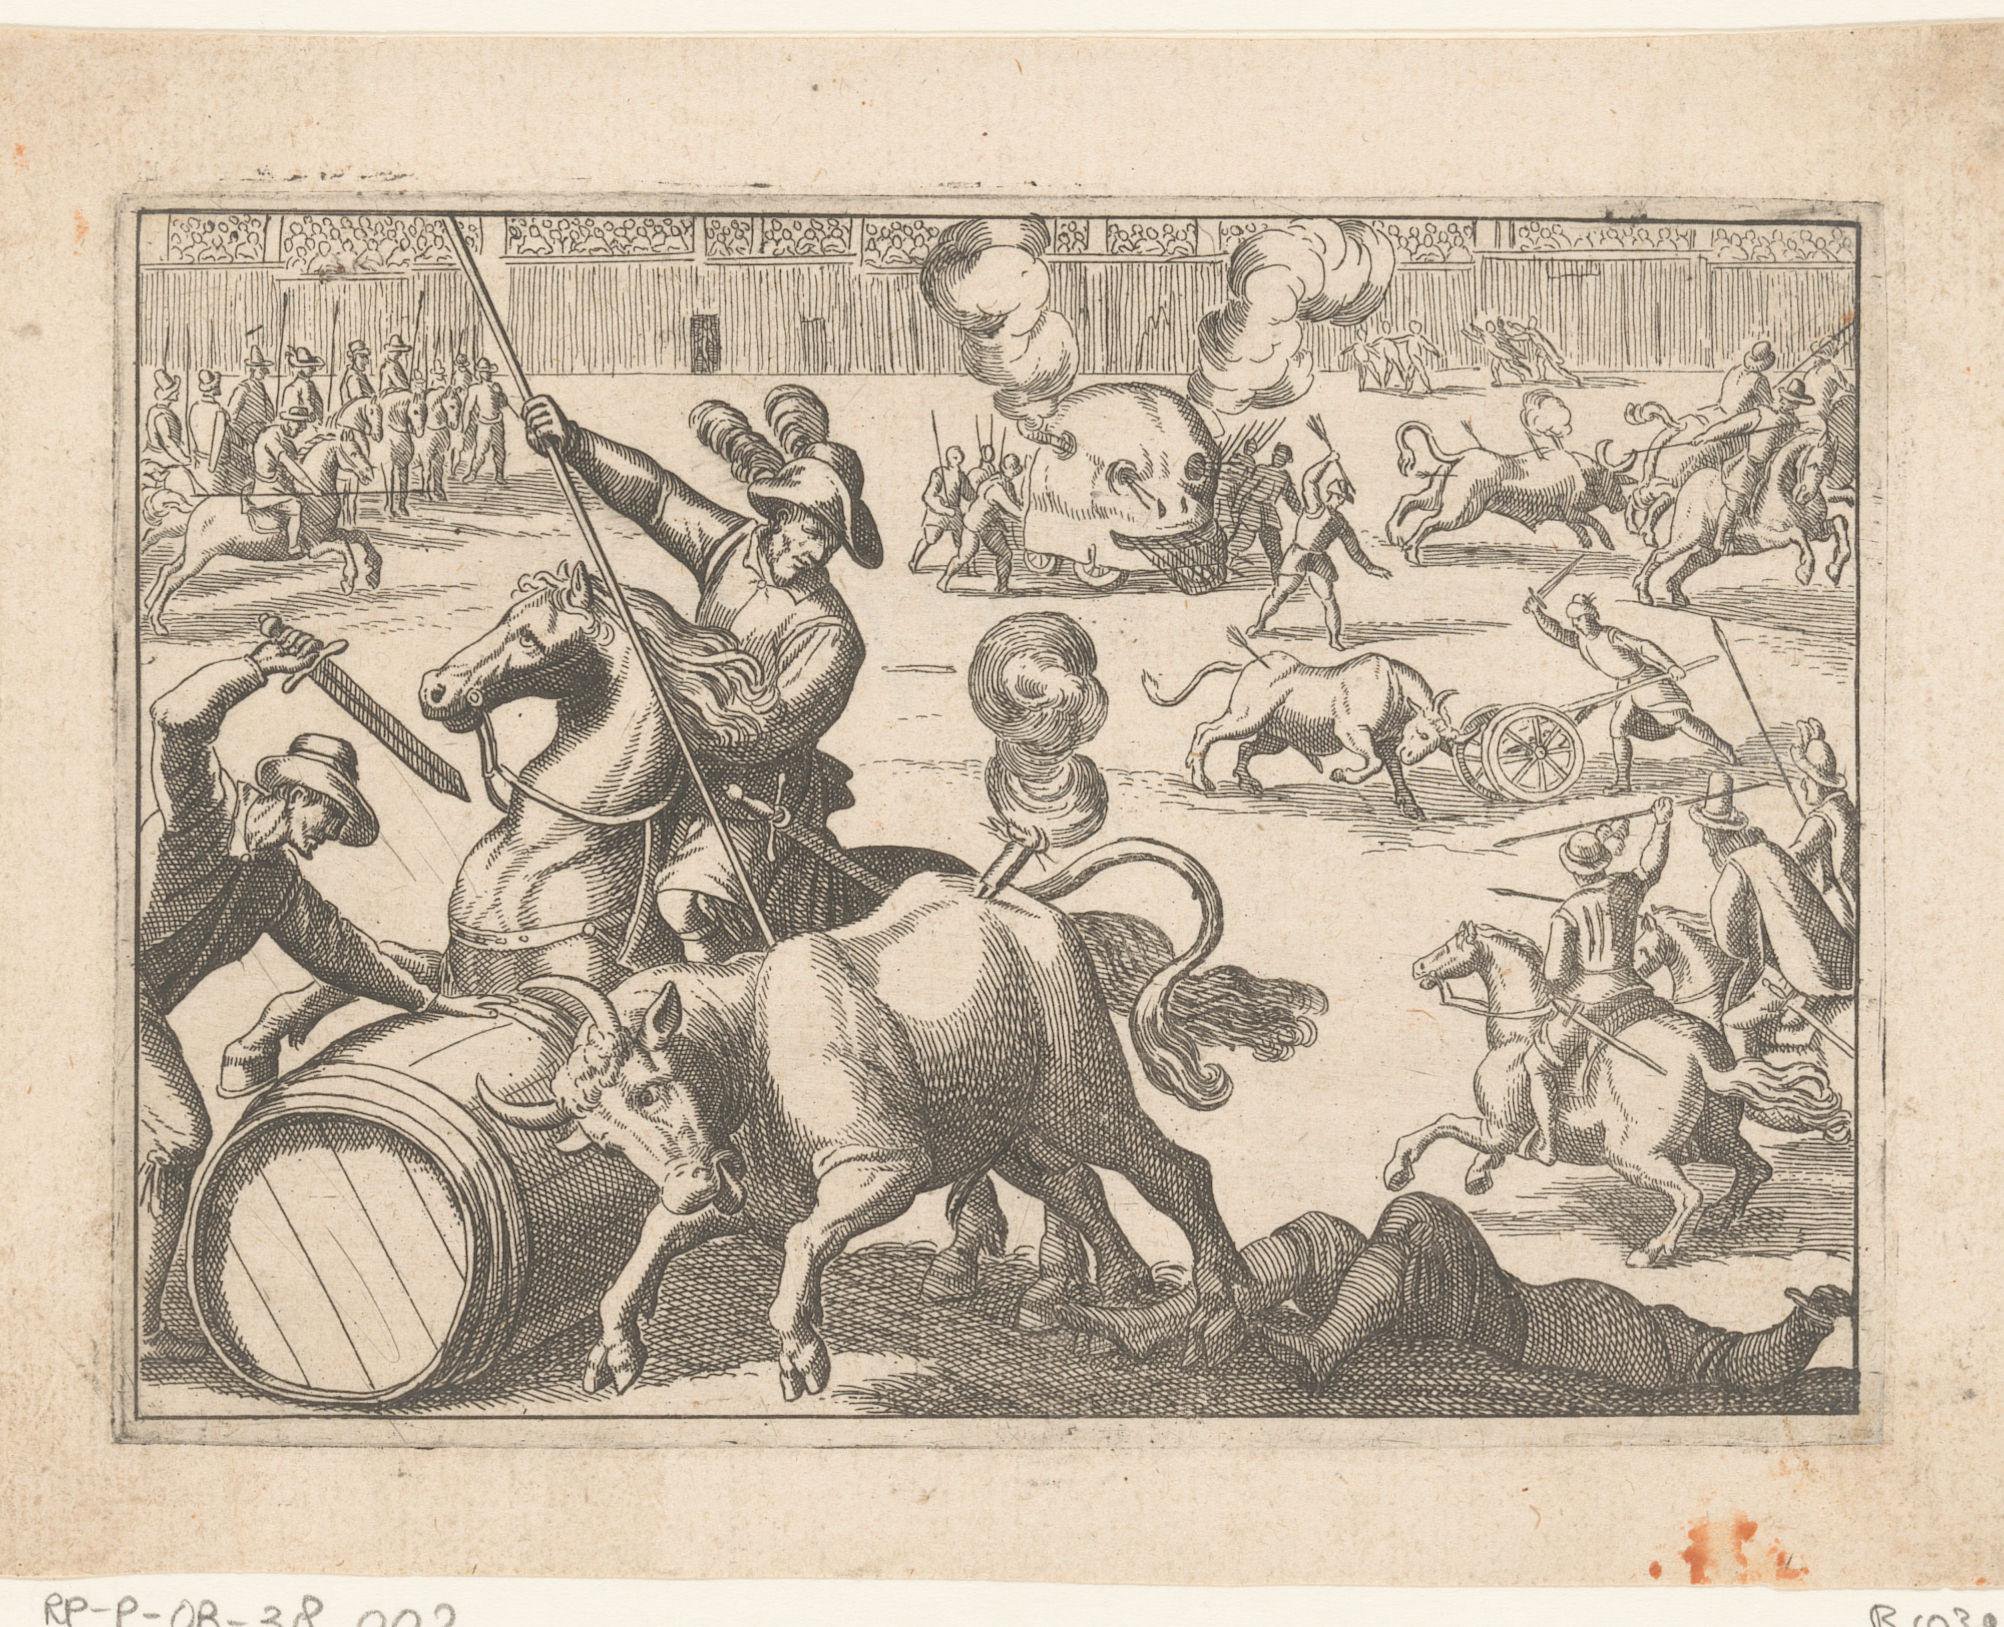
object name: print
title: Jachtscènes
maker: Anonymous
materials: paper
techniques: etching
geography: italy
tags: bull, hunter, hunters hunting (n.b.: in 1988-1990 this notation denoted the concept of 43c11421 'hunters resting during the hunt'), hunt ~ mammals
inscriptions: collector's mark: Lugt 2165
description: Deze prent maakt deel uit van een reeks jachtscènes. De originele serie door Antonio Tempesta bestaat uit 45 jachtscènes (+ opdracht en titelprent).